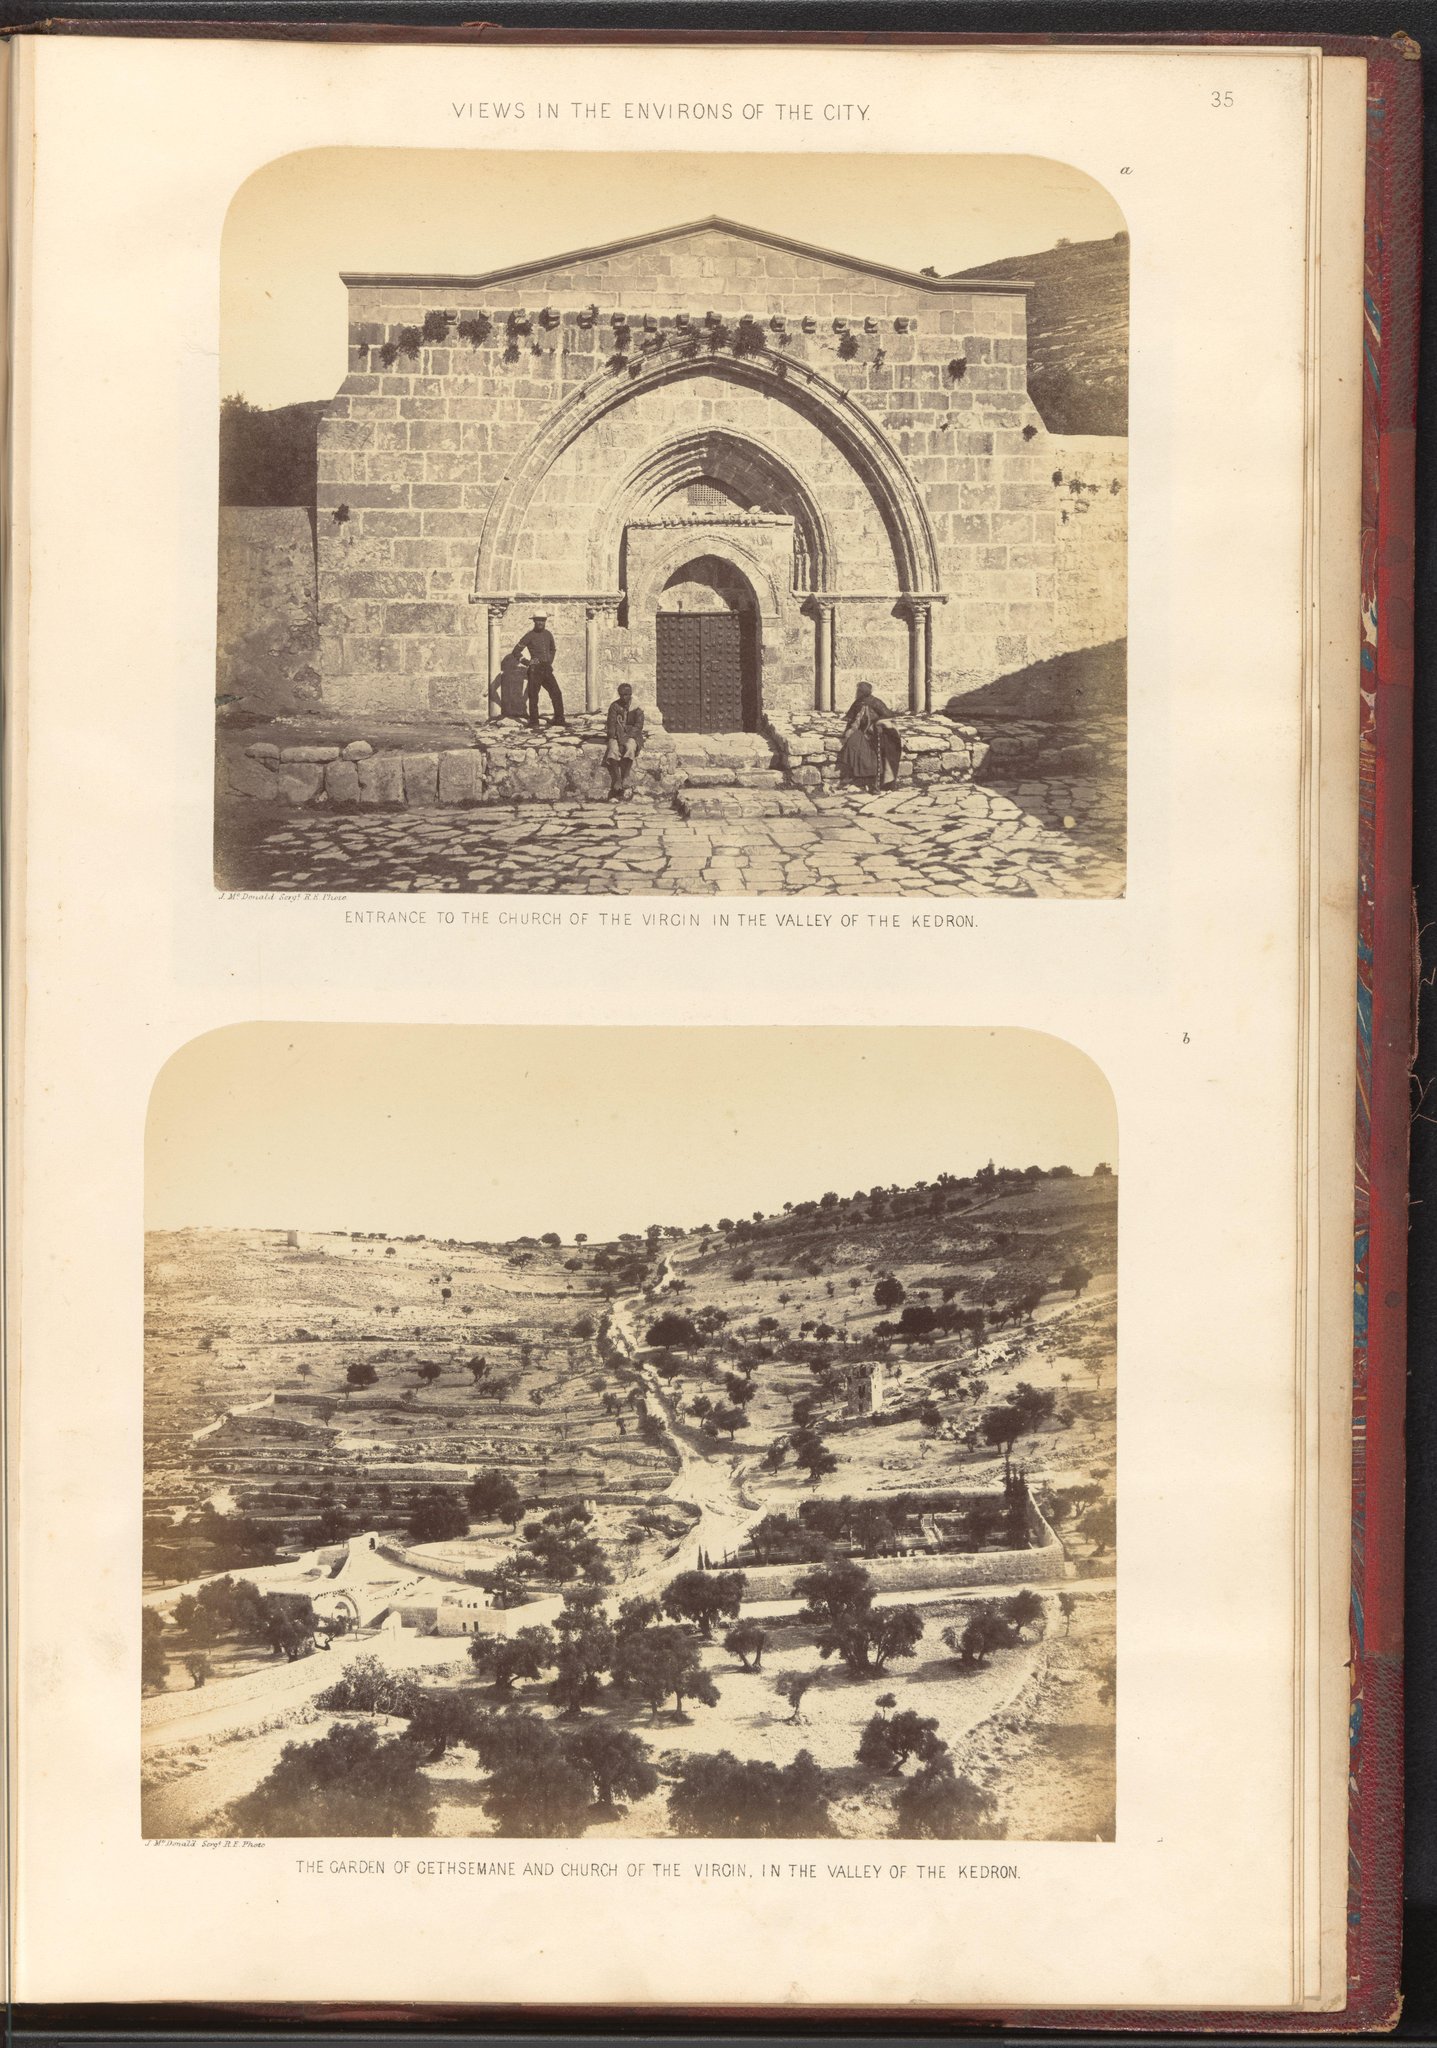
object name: page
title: The Garden of Gethsemane and Church of the Virgin, in the Valley of the Kedron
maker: james mcdonald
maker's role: fotograaf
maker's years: 1822-1885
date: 1860-1865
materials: paper, photographic support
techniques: albumen print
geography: jerusalem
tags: dale, valley, grave, tomb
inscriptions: inscription: ‘a’, inscription: ‘b’